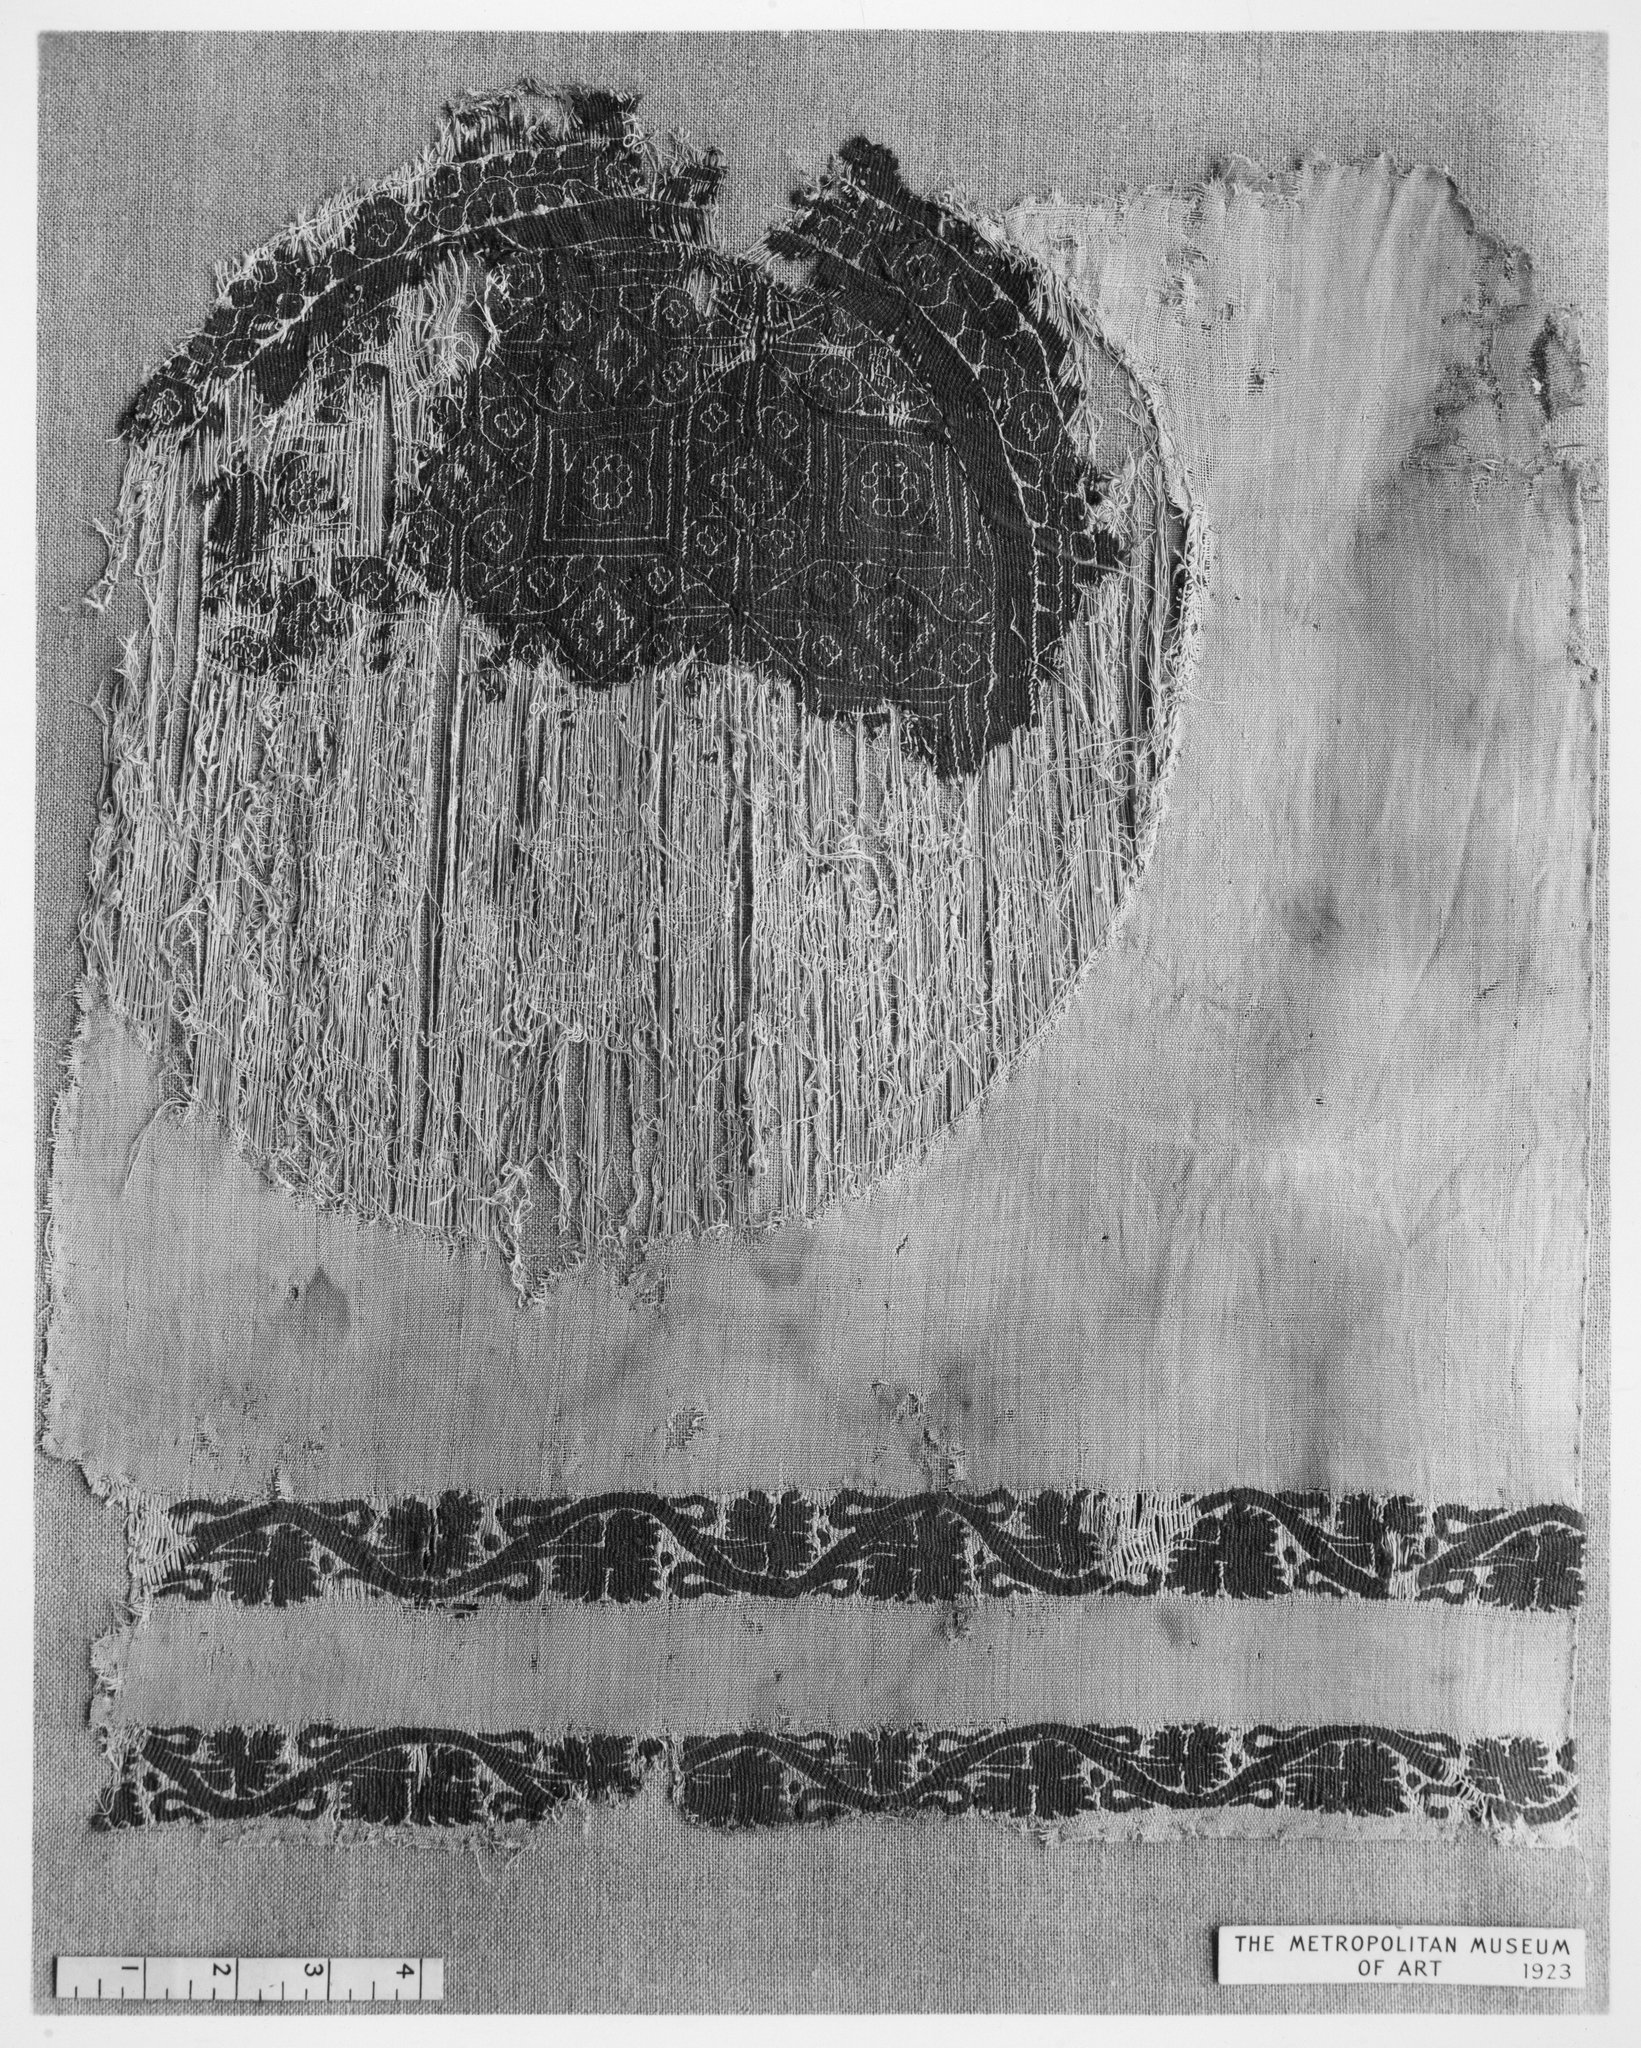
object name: textile fragment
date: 201-400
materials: linen, wool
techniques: weave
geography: egypt